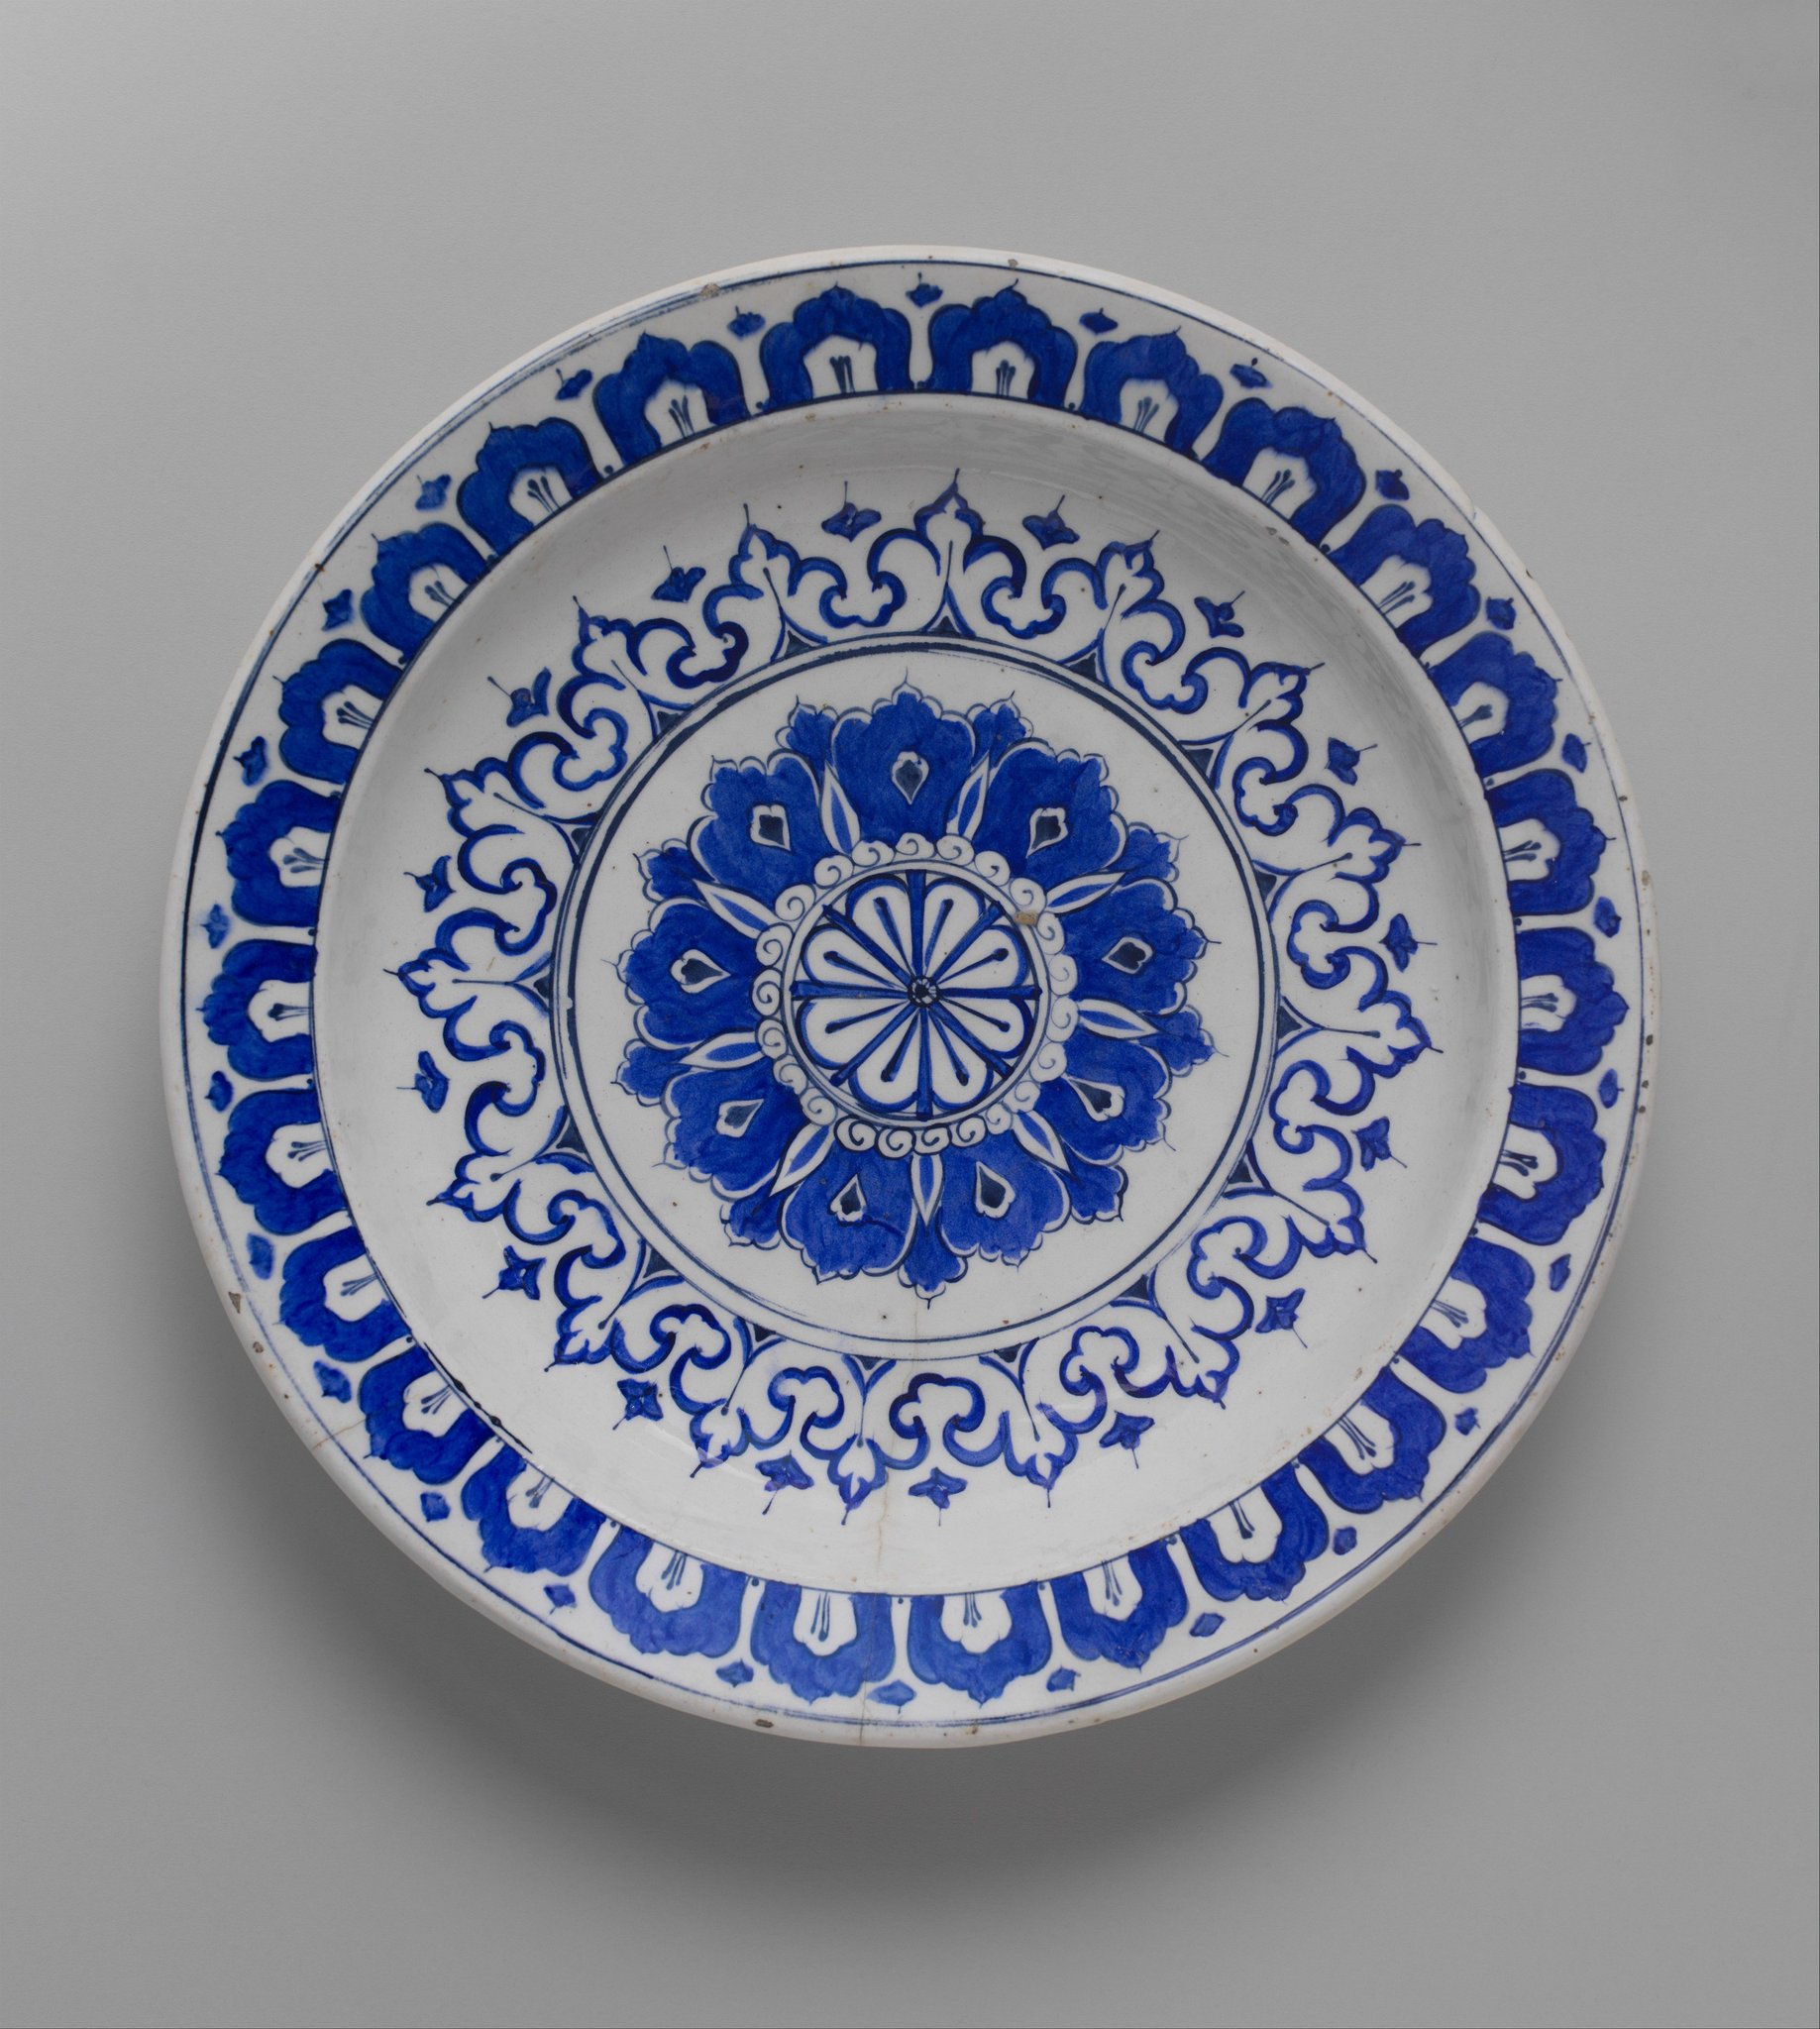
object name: dish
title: Dish with 'Kaleidoscope' Design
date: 1580-1585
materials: glaze, stonepaste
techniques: painting, polychrome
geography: turkey